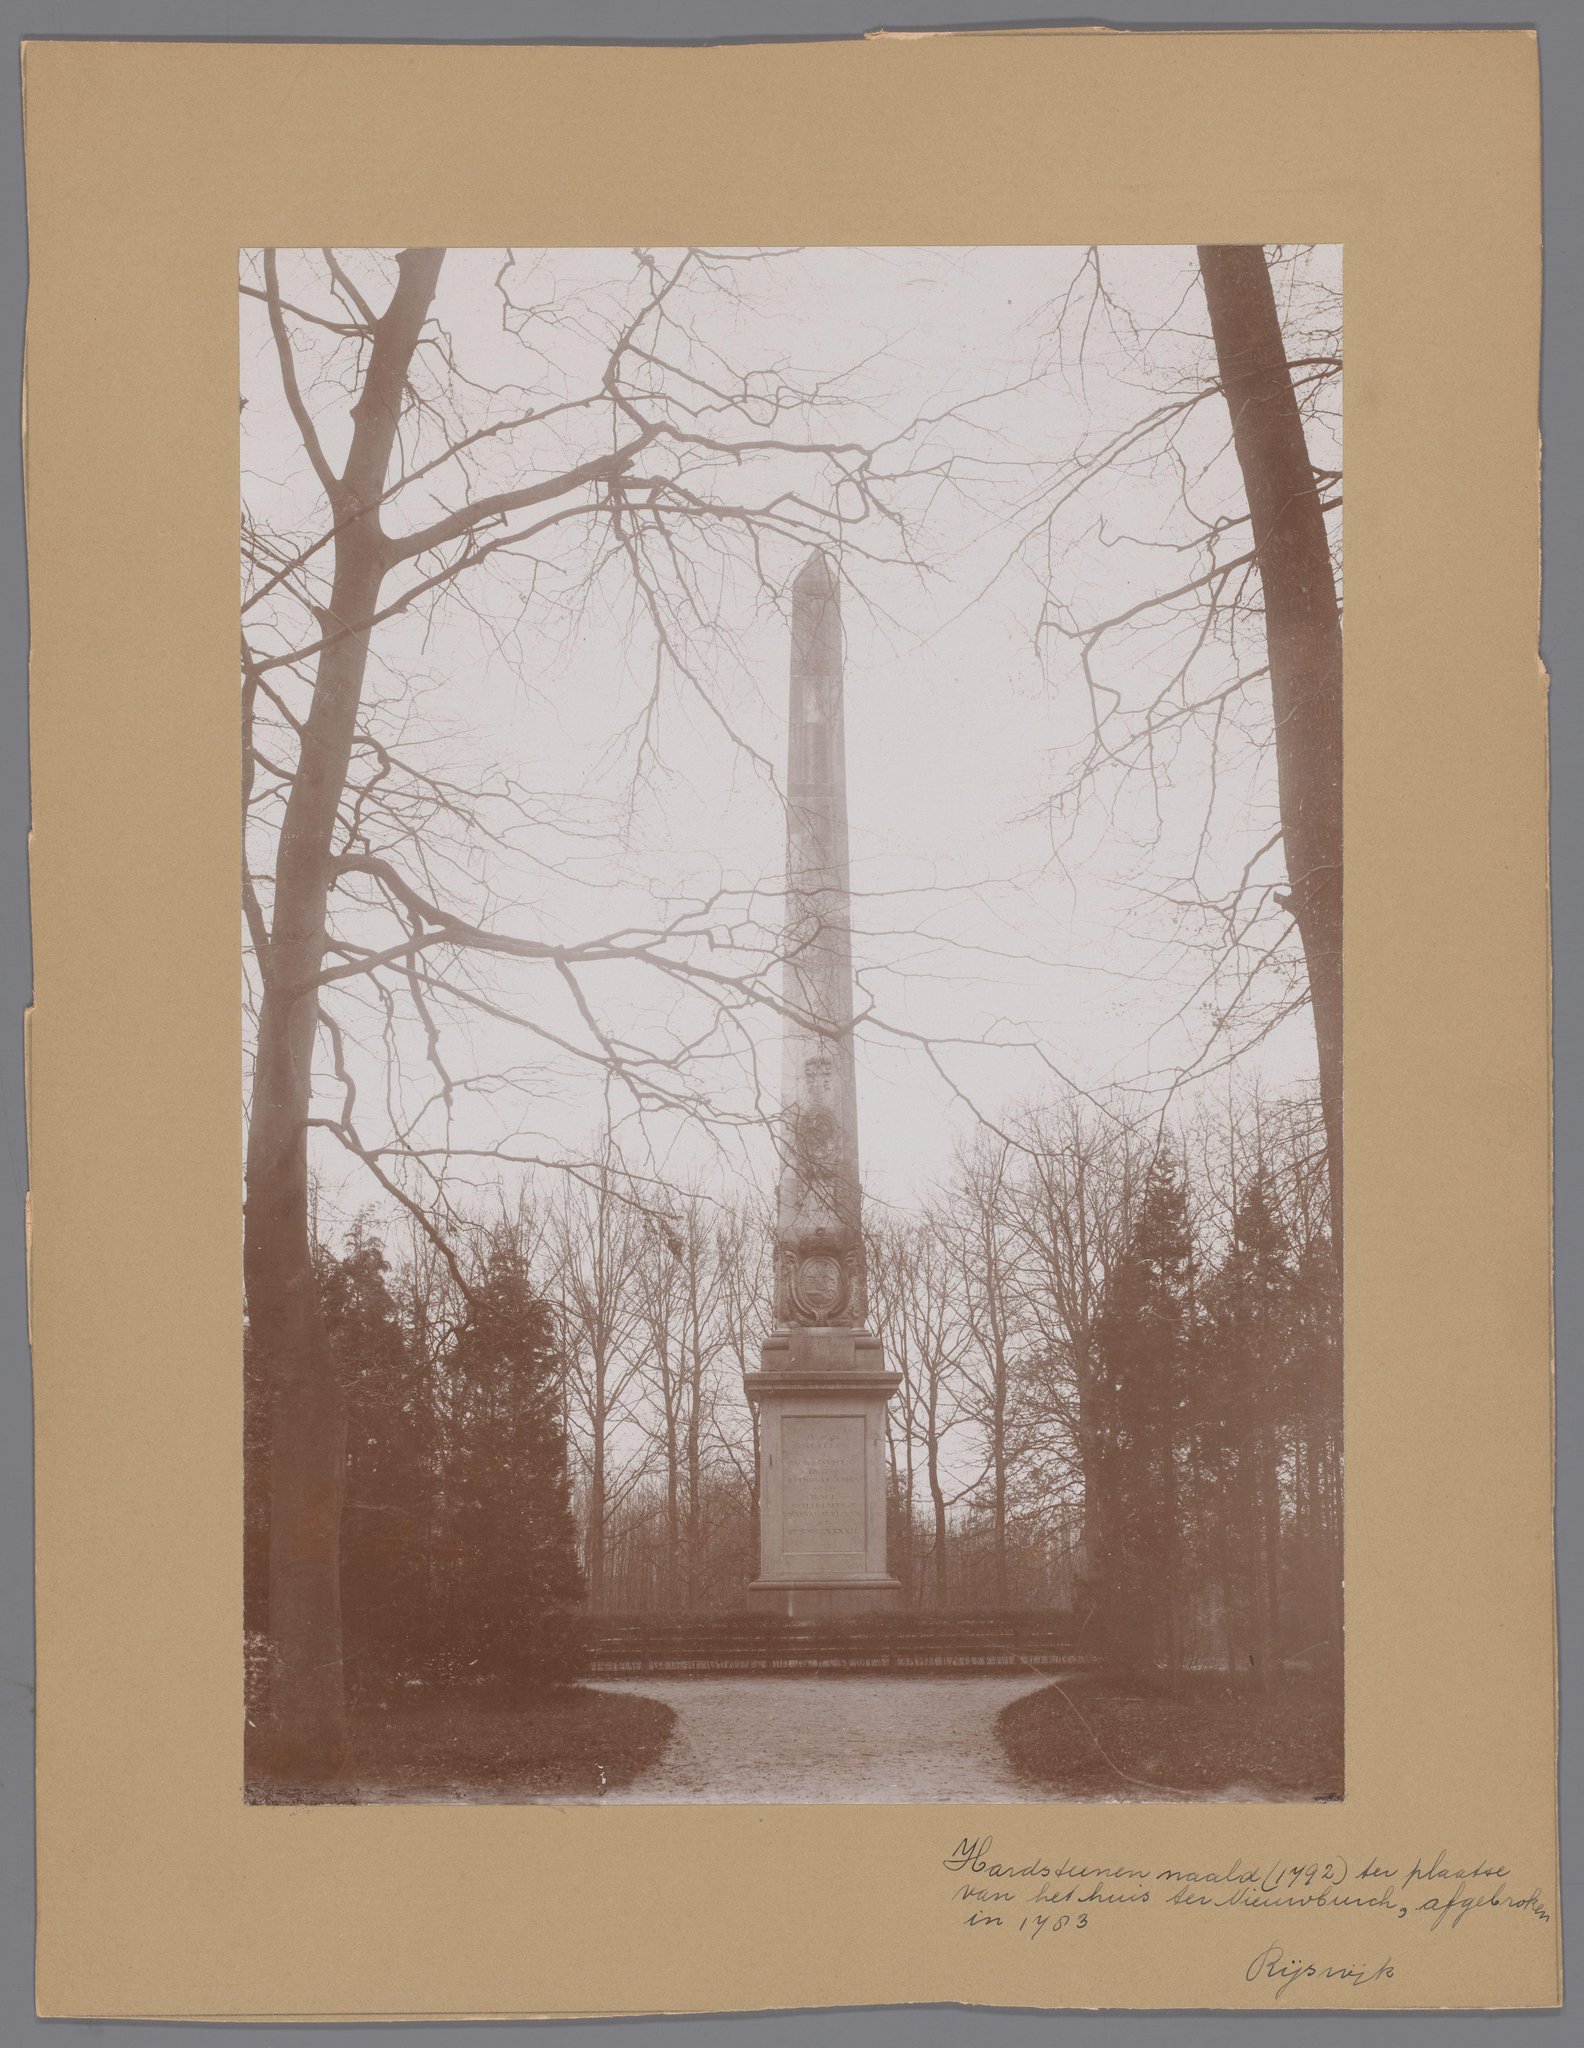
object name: photograph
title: Gezicht op de Naald van Rijswijk in het Rijswijkse Bos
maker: anoniem (monumentenzorg)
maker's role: fotograaf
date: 1890-1920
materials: cardboard, photographic support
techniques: collodion silver print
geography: rijswijk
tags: monument, statue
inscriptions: annotation: ‘1/2 R981/ Rijswijk?’, annotation: ‘Handsteenen naald (1792) ten plaatse van het huis er Nieuwburch, afgebroken in 1783/ Rijswijk’